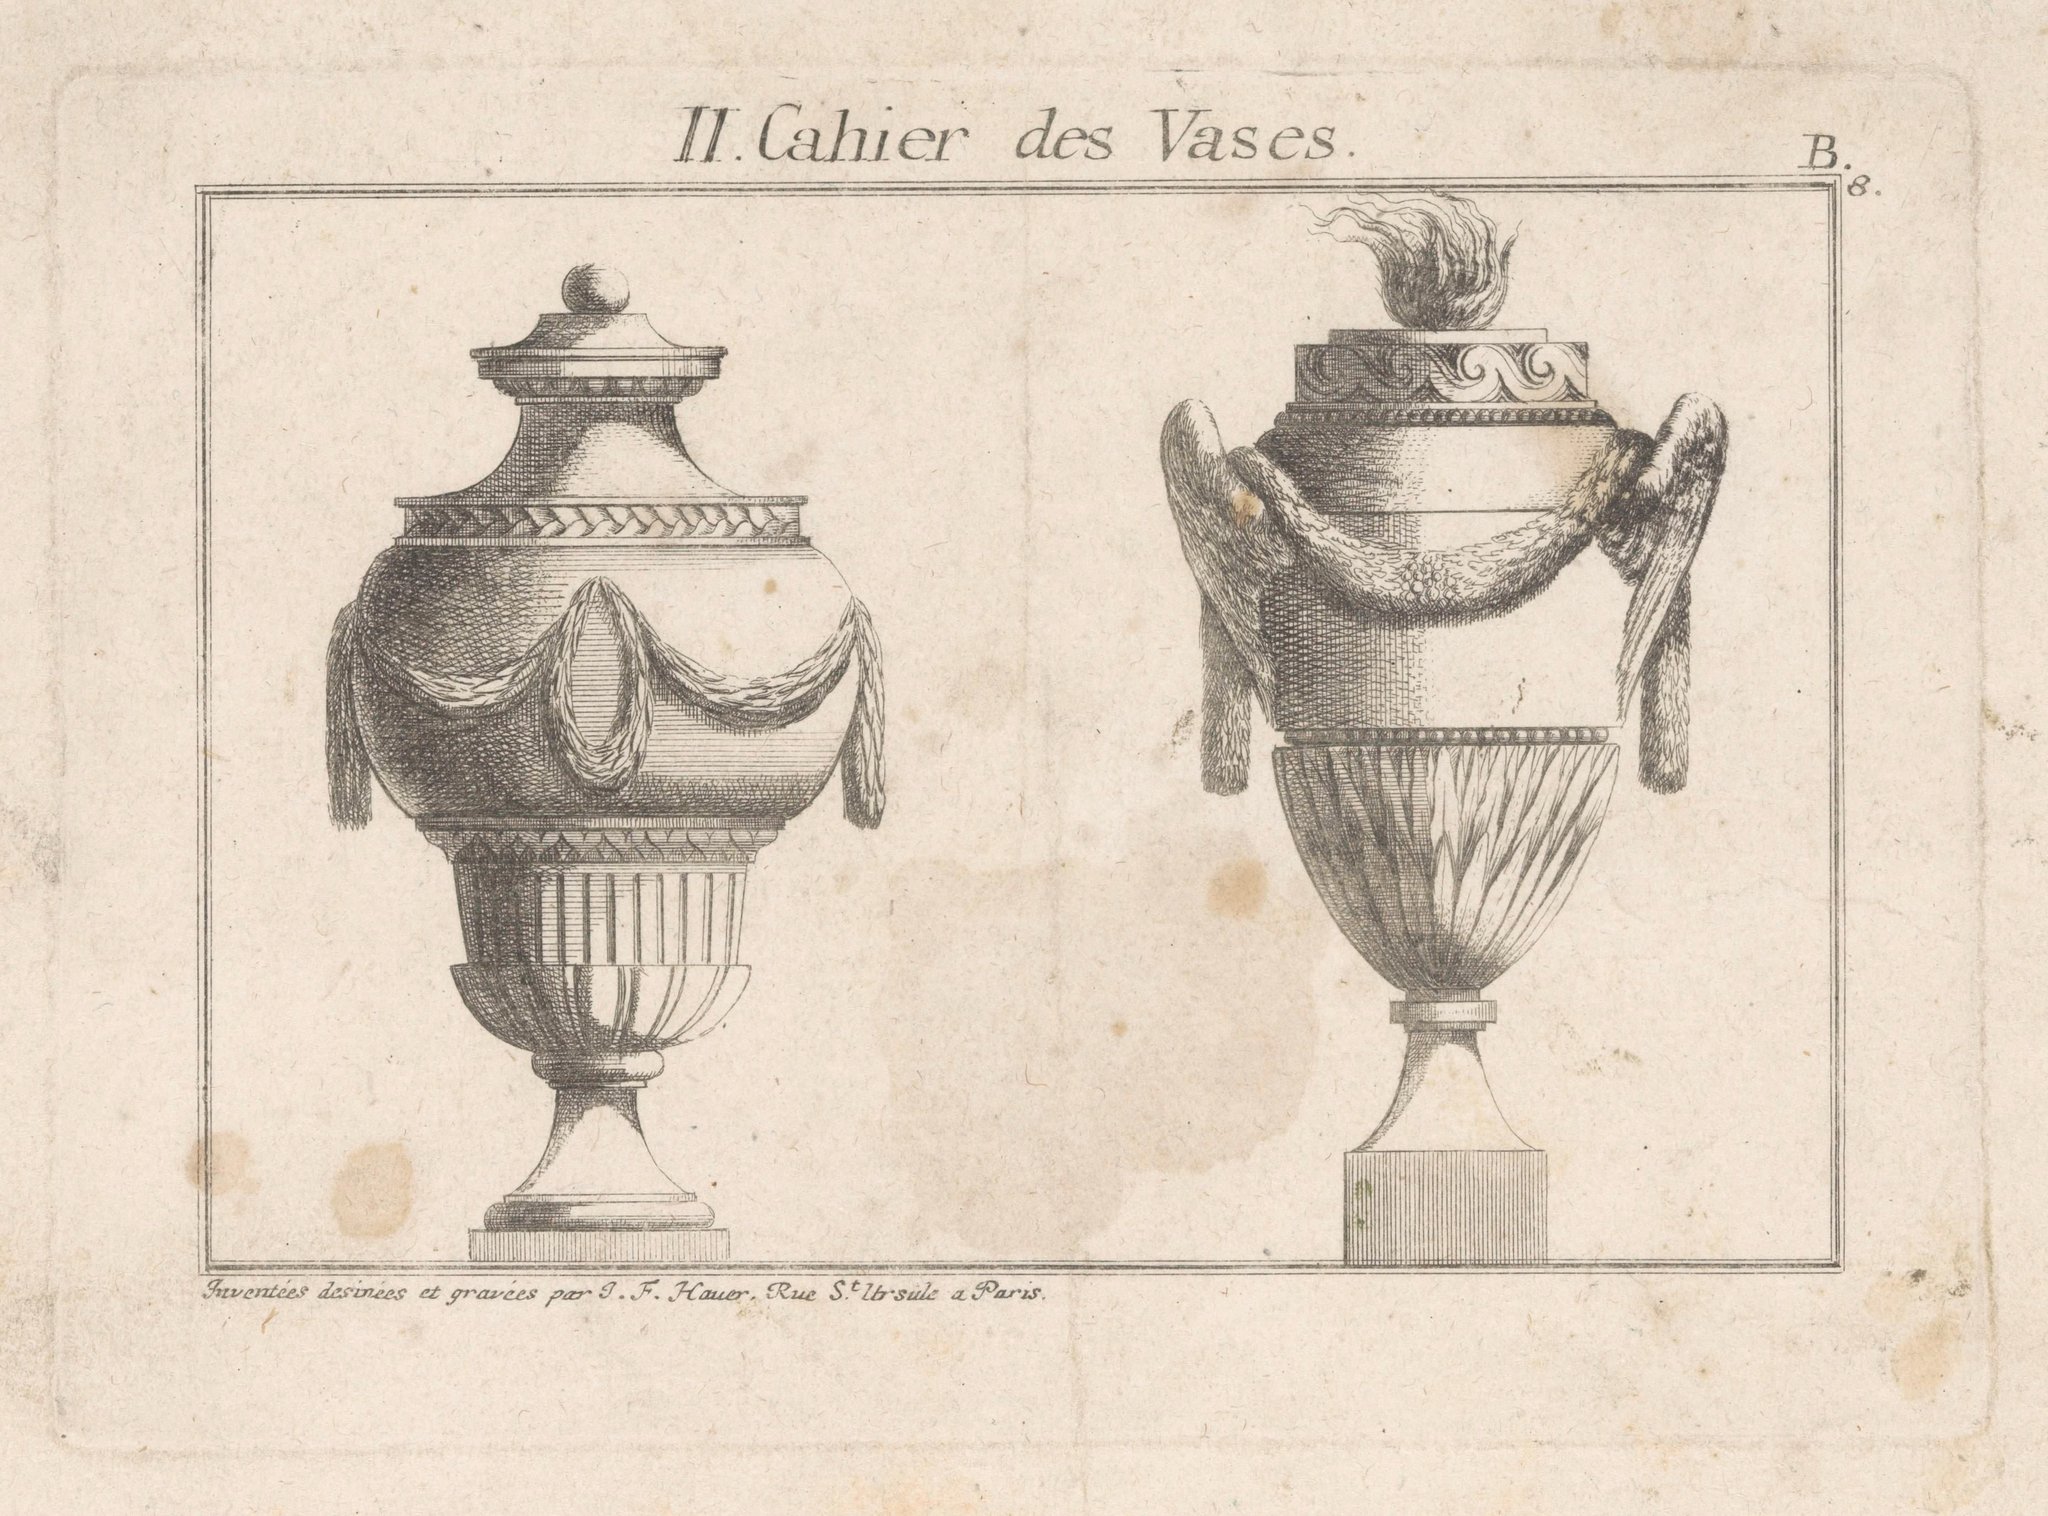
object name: print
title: Desseins de la Mode neuve au Gout antique (...)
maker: johann thomas hauer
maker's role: print maker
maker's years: 1748-1820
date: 1758-1820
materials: paper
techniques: engraving, etching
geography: paris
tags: vase ~ ornament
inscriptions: collector's mark: Lugt 2760, collector's mark: Lugt 2228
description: Ontwerpen voor twee vazen met guirlandes en ornamenten. De rechtervaas met vlam en met oren in de vorm van vleugels.